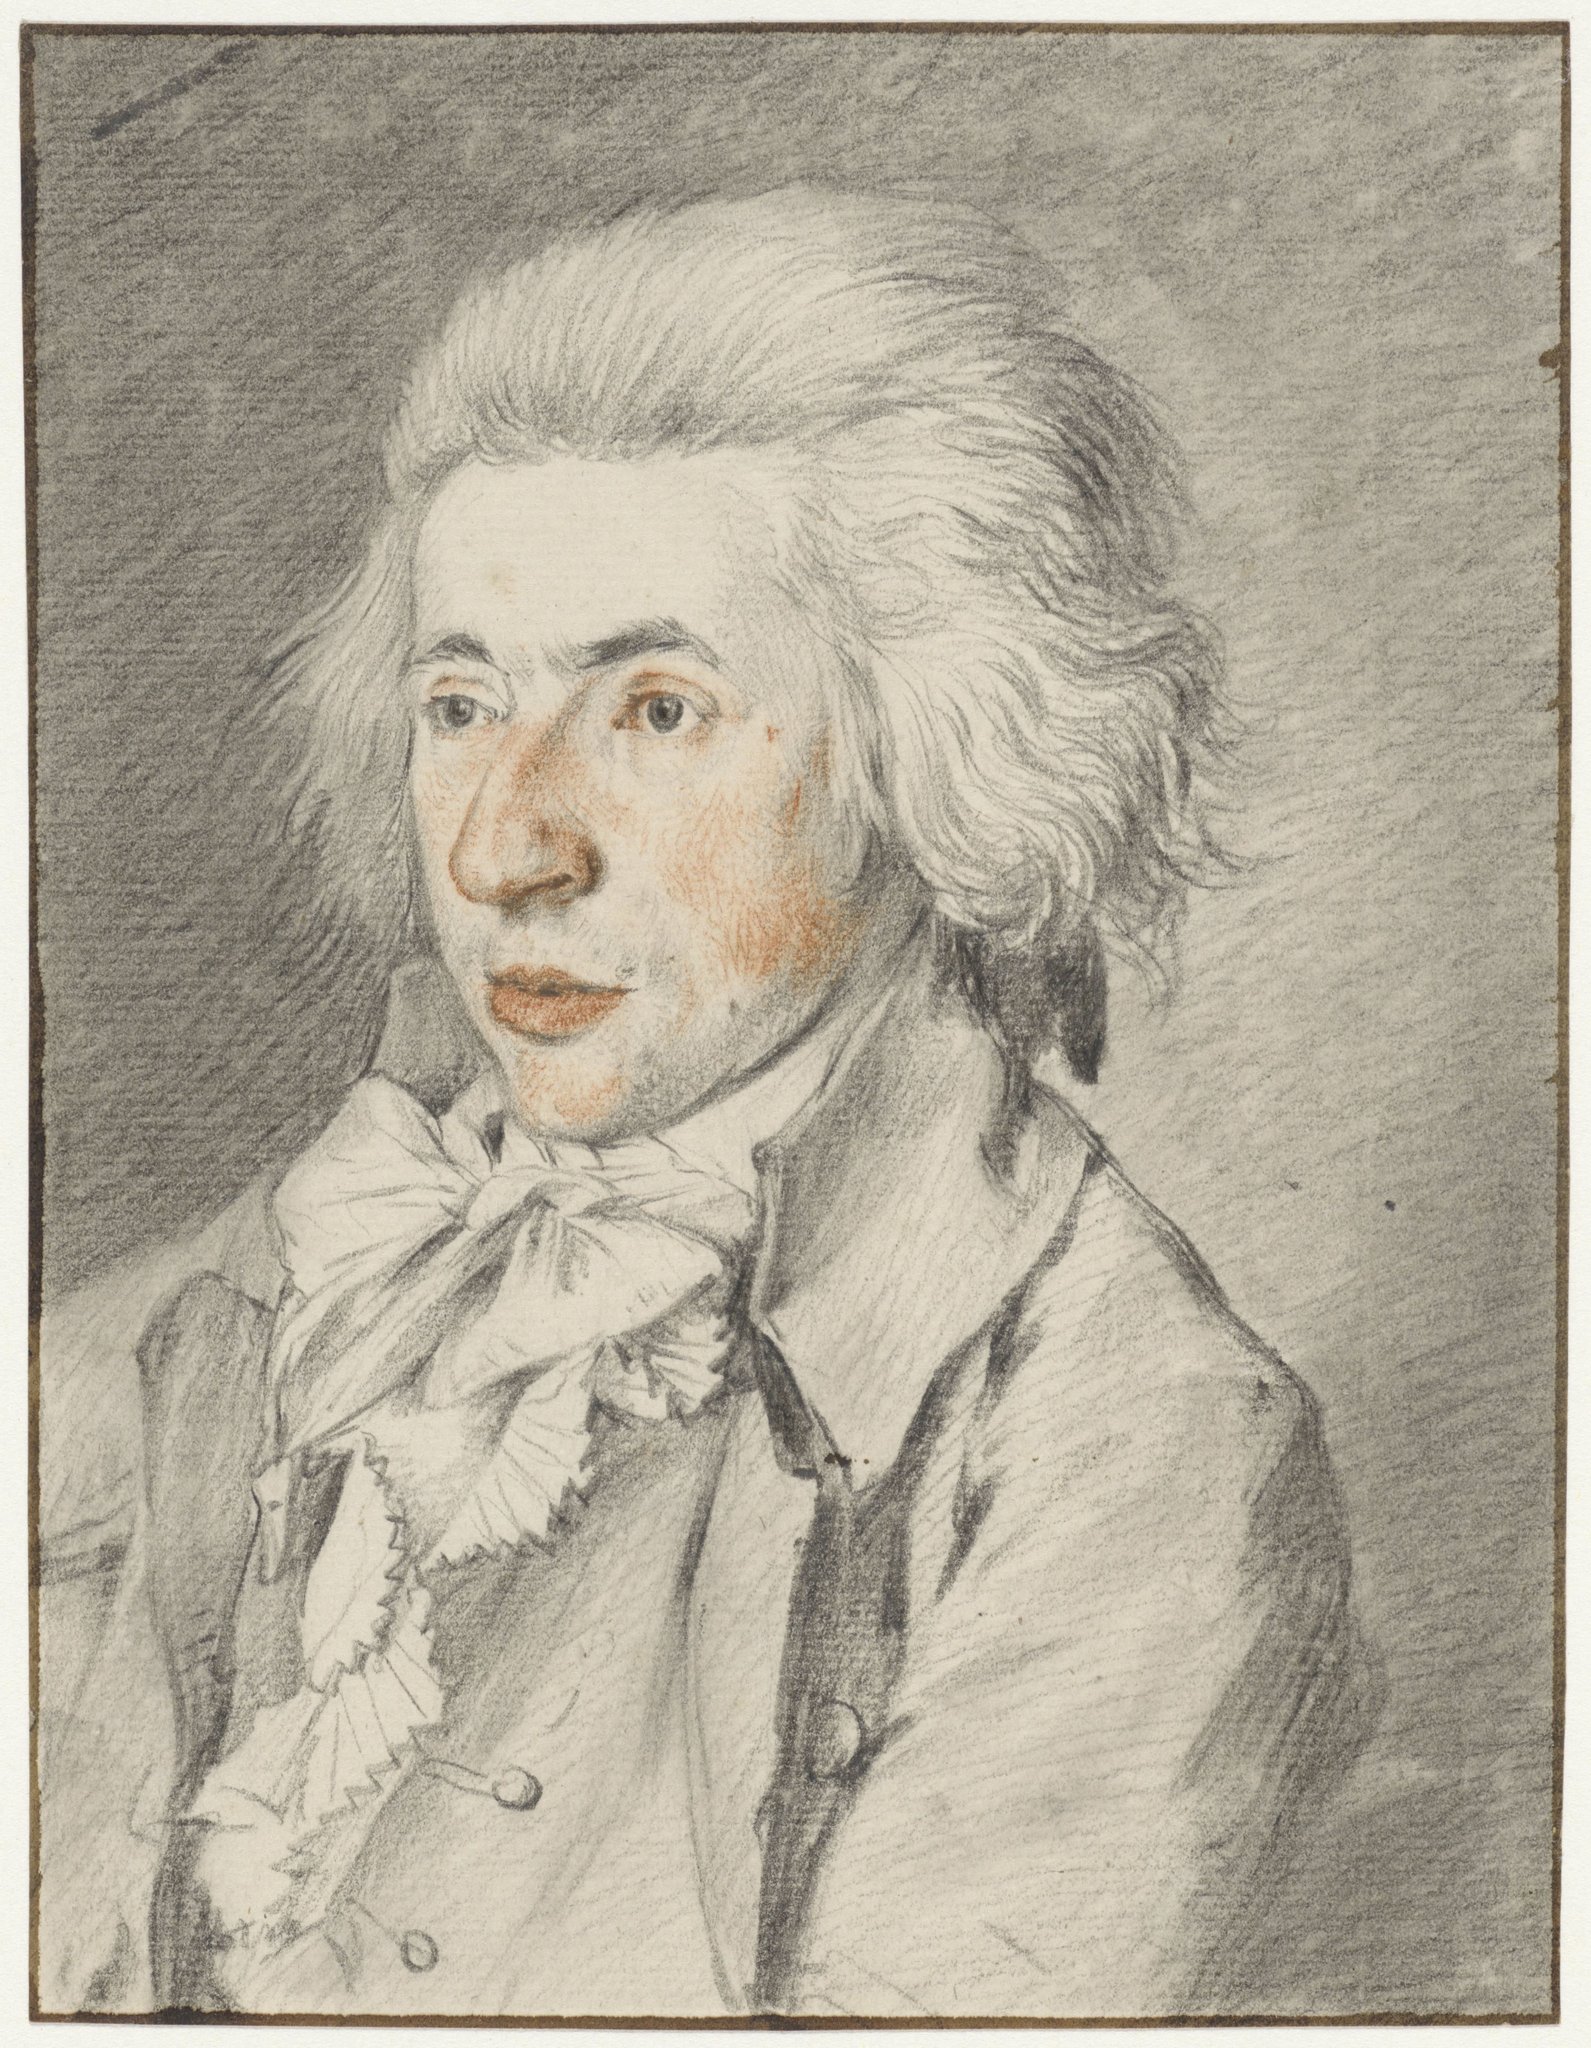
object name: drawing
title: Portret van Carel Lodewijk Hansen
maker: wybrand hendriks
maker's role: draughtsman, painter, print maker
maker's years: 1744-1831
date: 1784-1831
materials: chalk, paper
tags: carel lodewijk hansen, historical persons, portrait, self-portrait of painter, portrait, self-portrait of artist, portrait, self-portrait of draughtsman